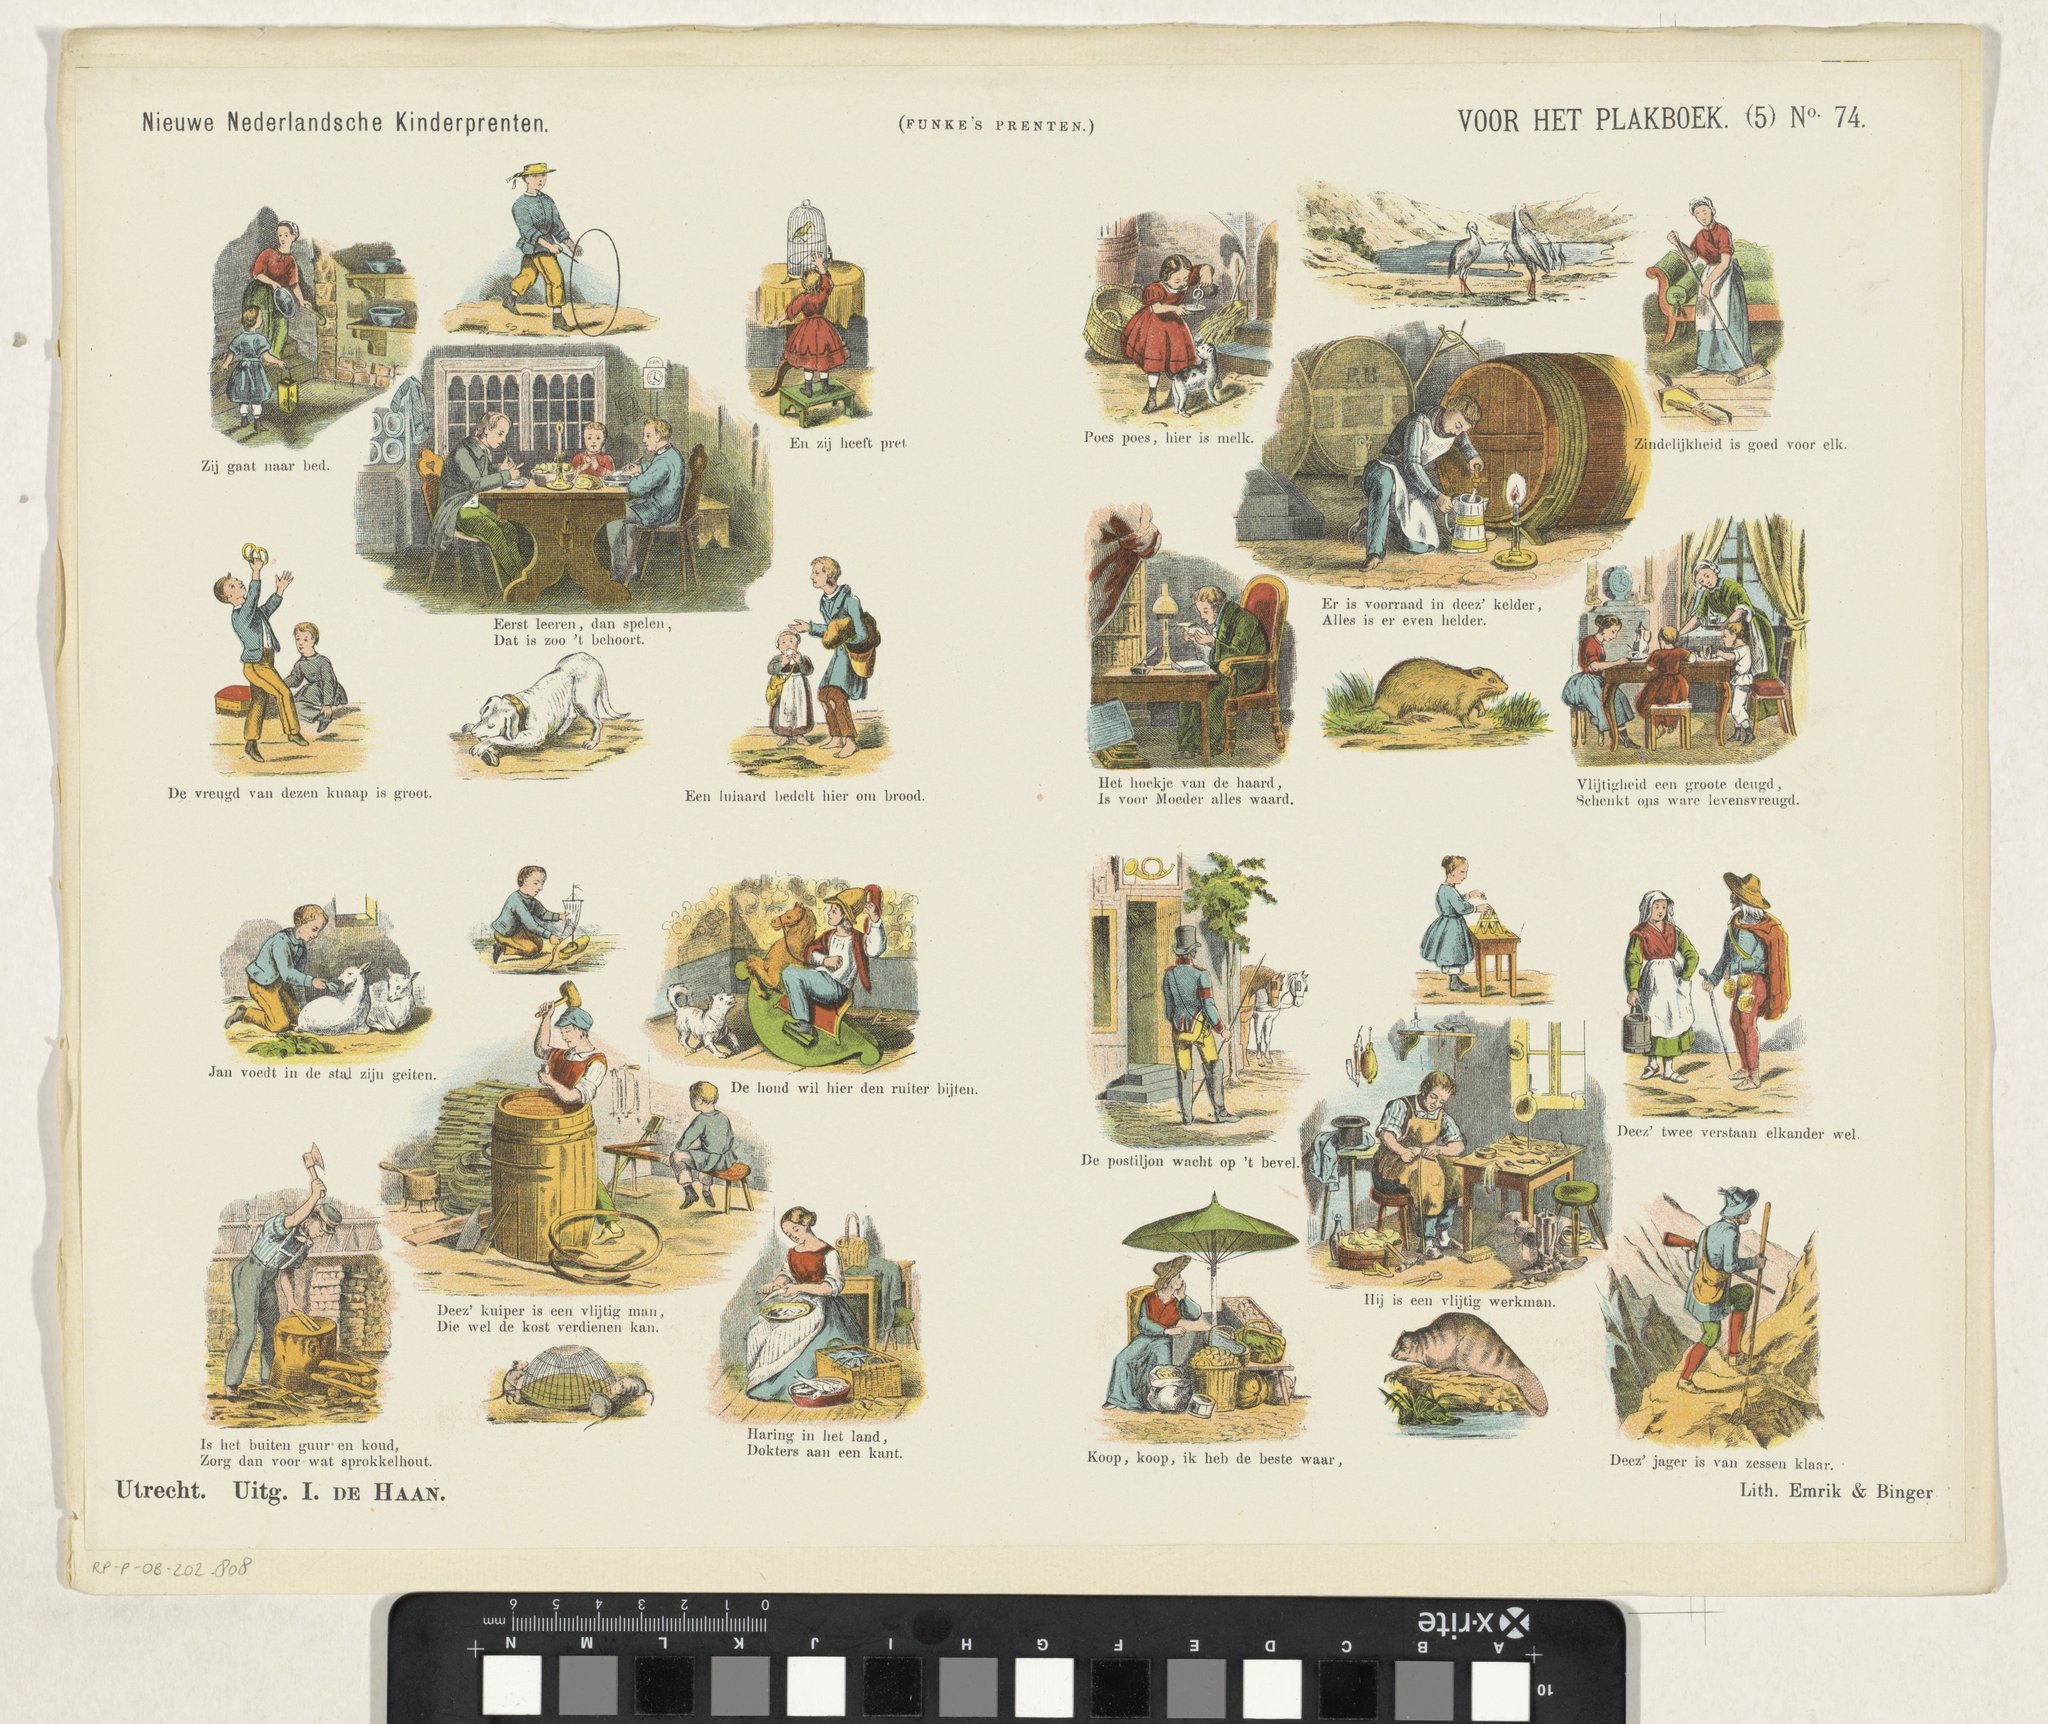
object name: popular print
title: Funke's prenten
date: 1875-1903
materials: paper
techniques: lithograph, letterpress printing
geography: utrecht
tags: craft-production, skilled handiwork, children's games and plays, animals, crafts and industries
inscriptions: collector's mark: Lugt 2760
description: Blad met 28 voorstellingen van verschillende aard, waaronder voorstellingen van dieren, spelende kinderen en ambachtslieden. Onder elke afbeelding een onderschrift. Genummerd rechtsboven: No. 74.